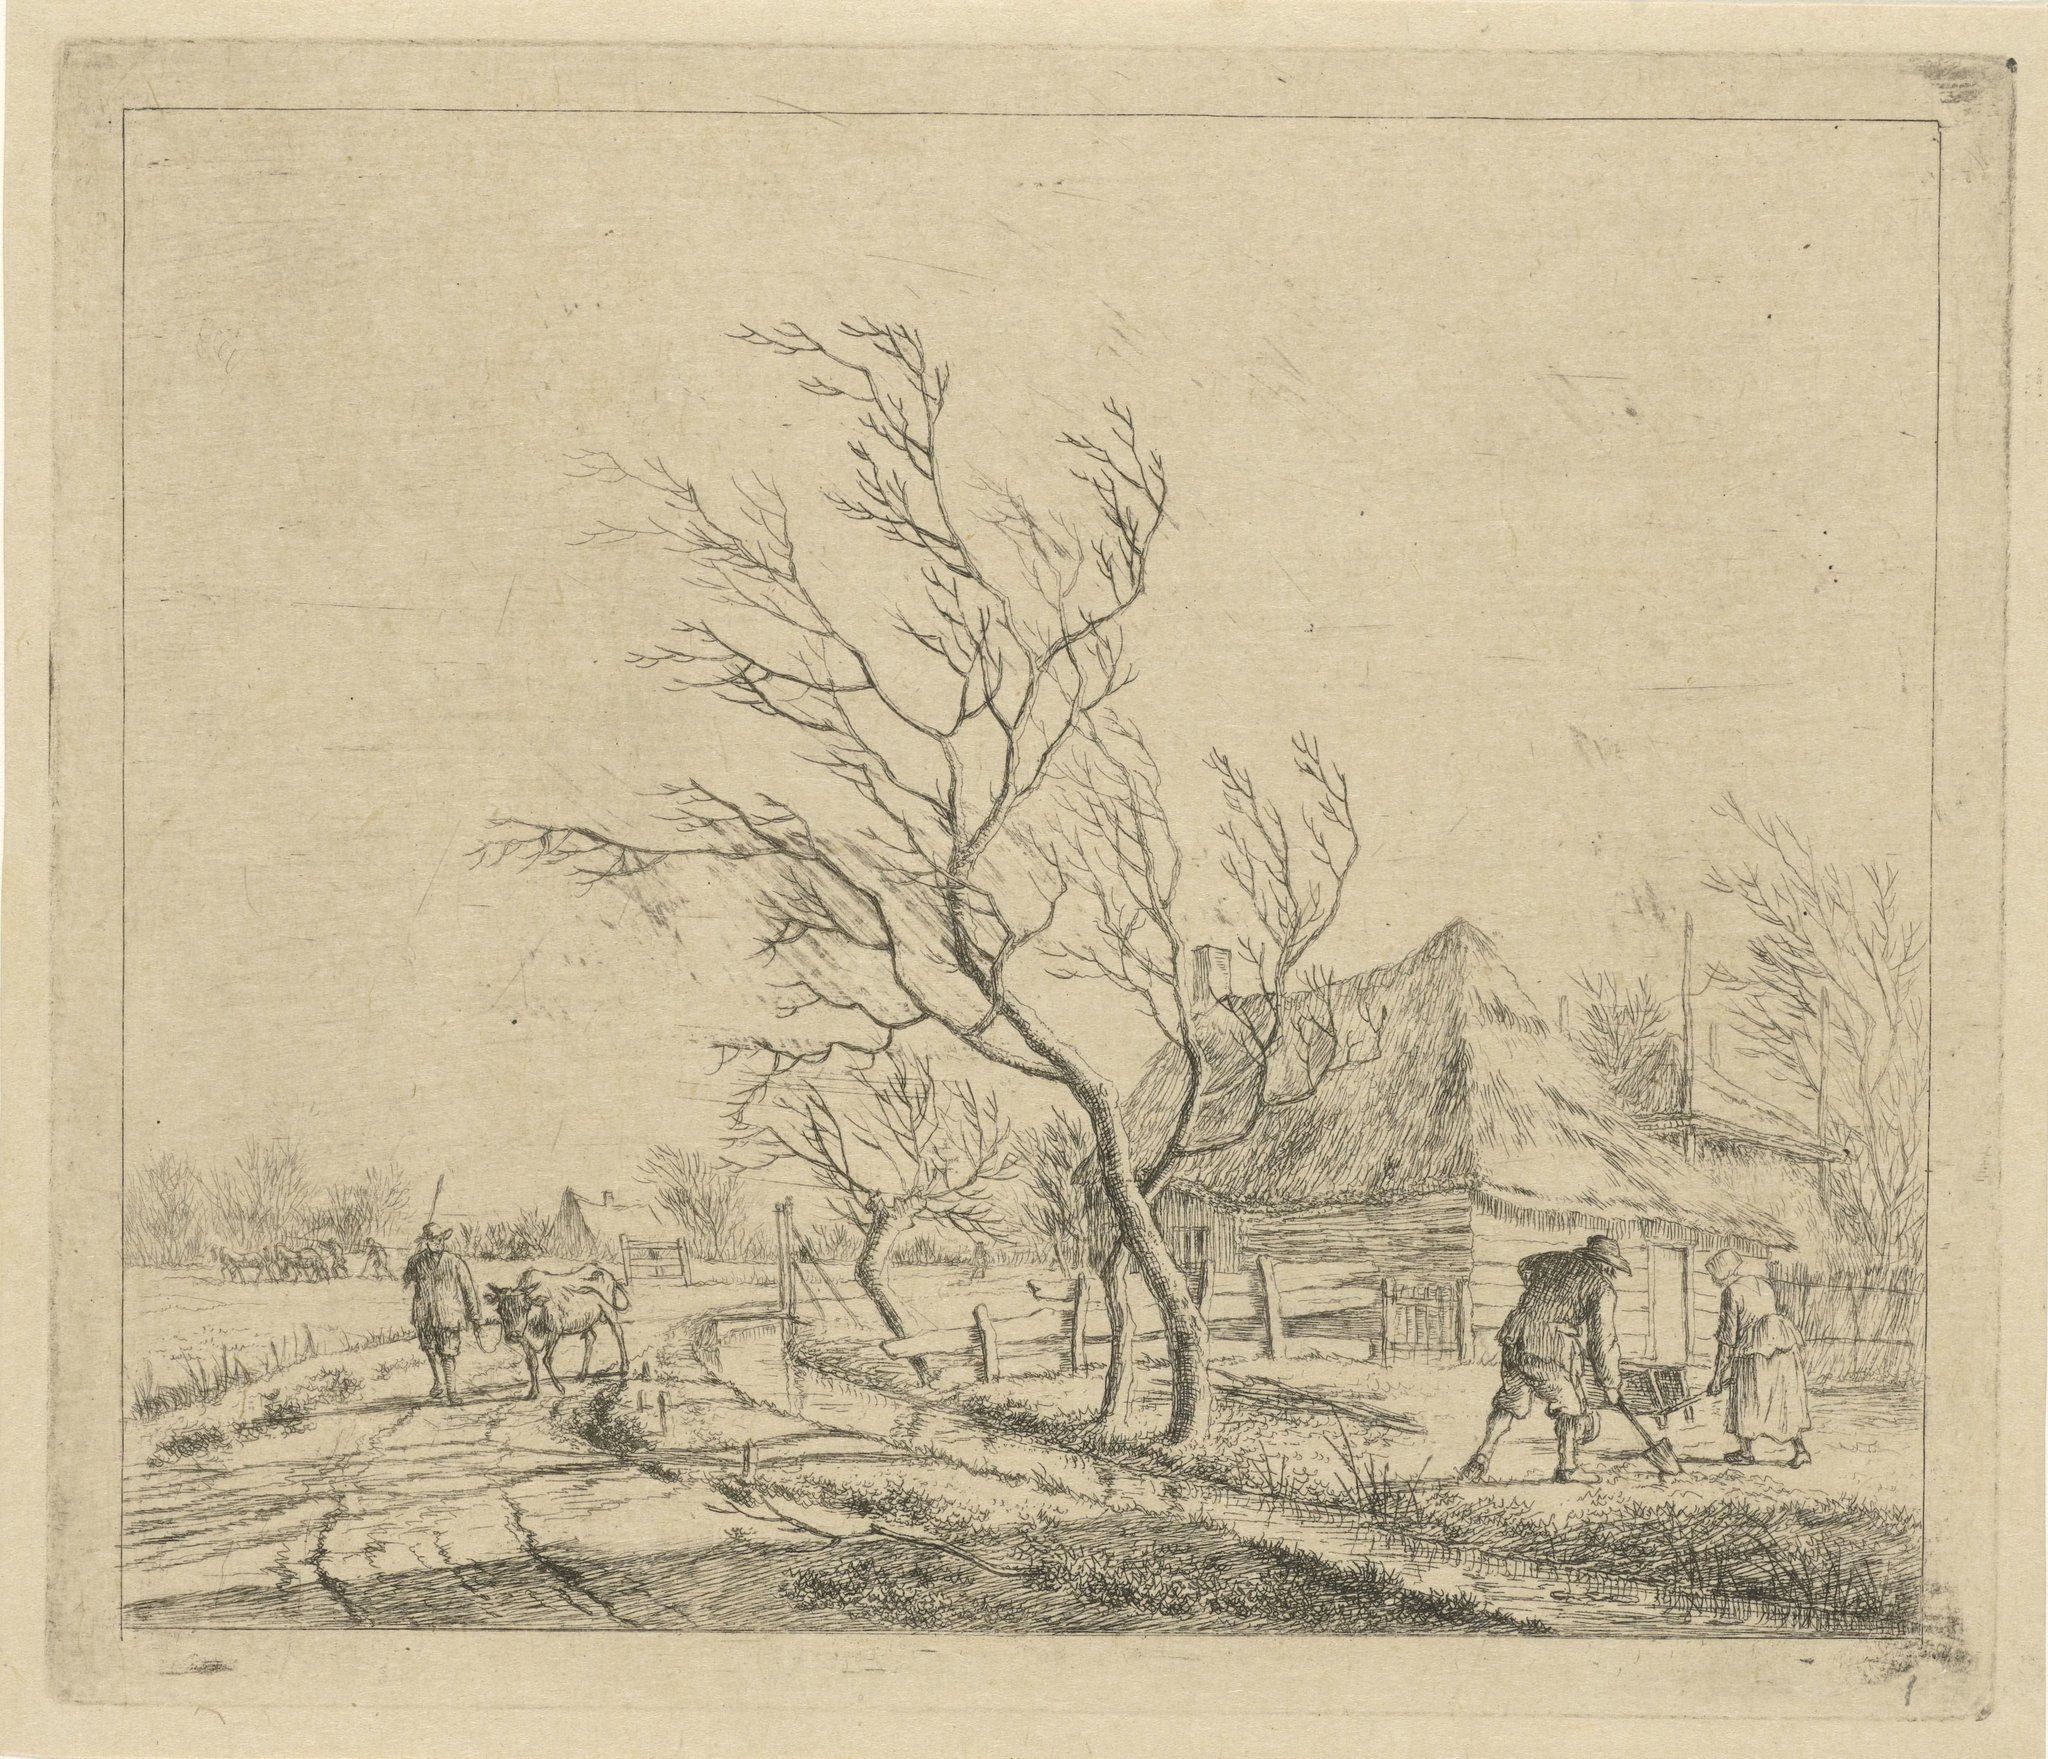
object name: print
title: Maart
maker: johannes janson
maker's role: draughtsman, painter, print maker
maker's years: 1729-1784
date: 1783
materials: paper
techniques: etching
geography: leiden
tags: landscape symbolizing march, farmers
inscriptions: collector's mark: Lugt 240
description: Landschap met boerderij, boer met schep en boerin met kruiwagen, aan het werk op hun land. Links een pad met een man met koe. Links op de achtergrond boeren en paarden op een akker. Vóór de lucht. Vierde prent uit een serie van dertien met maanden.